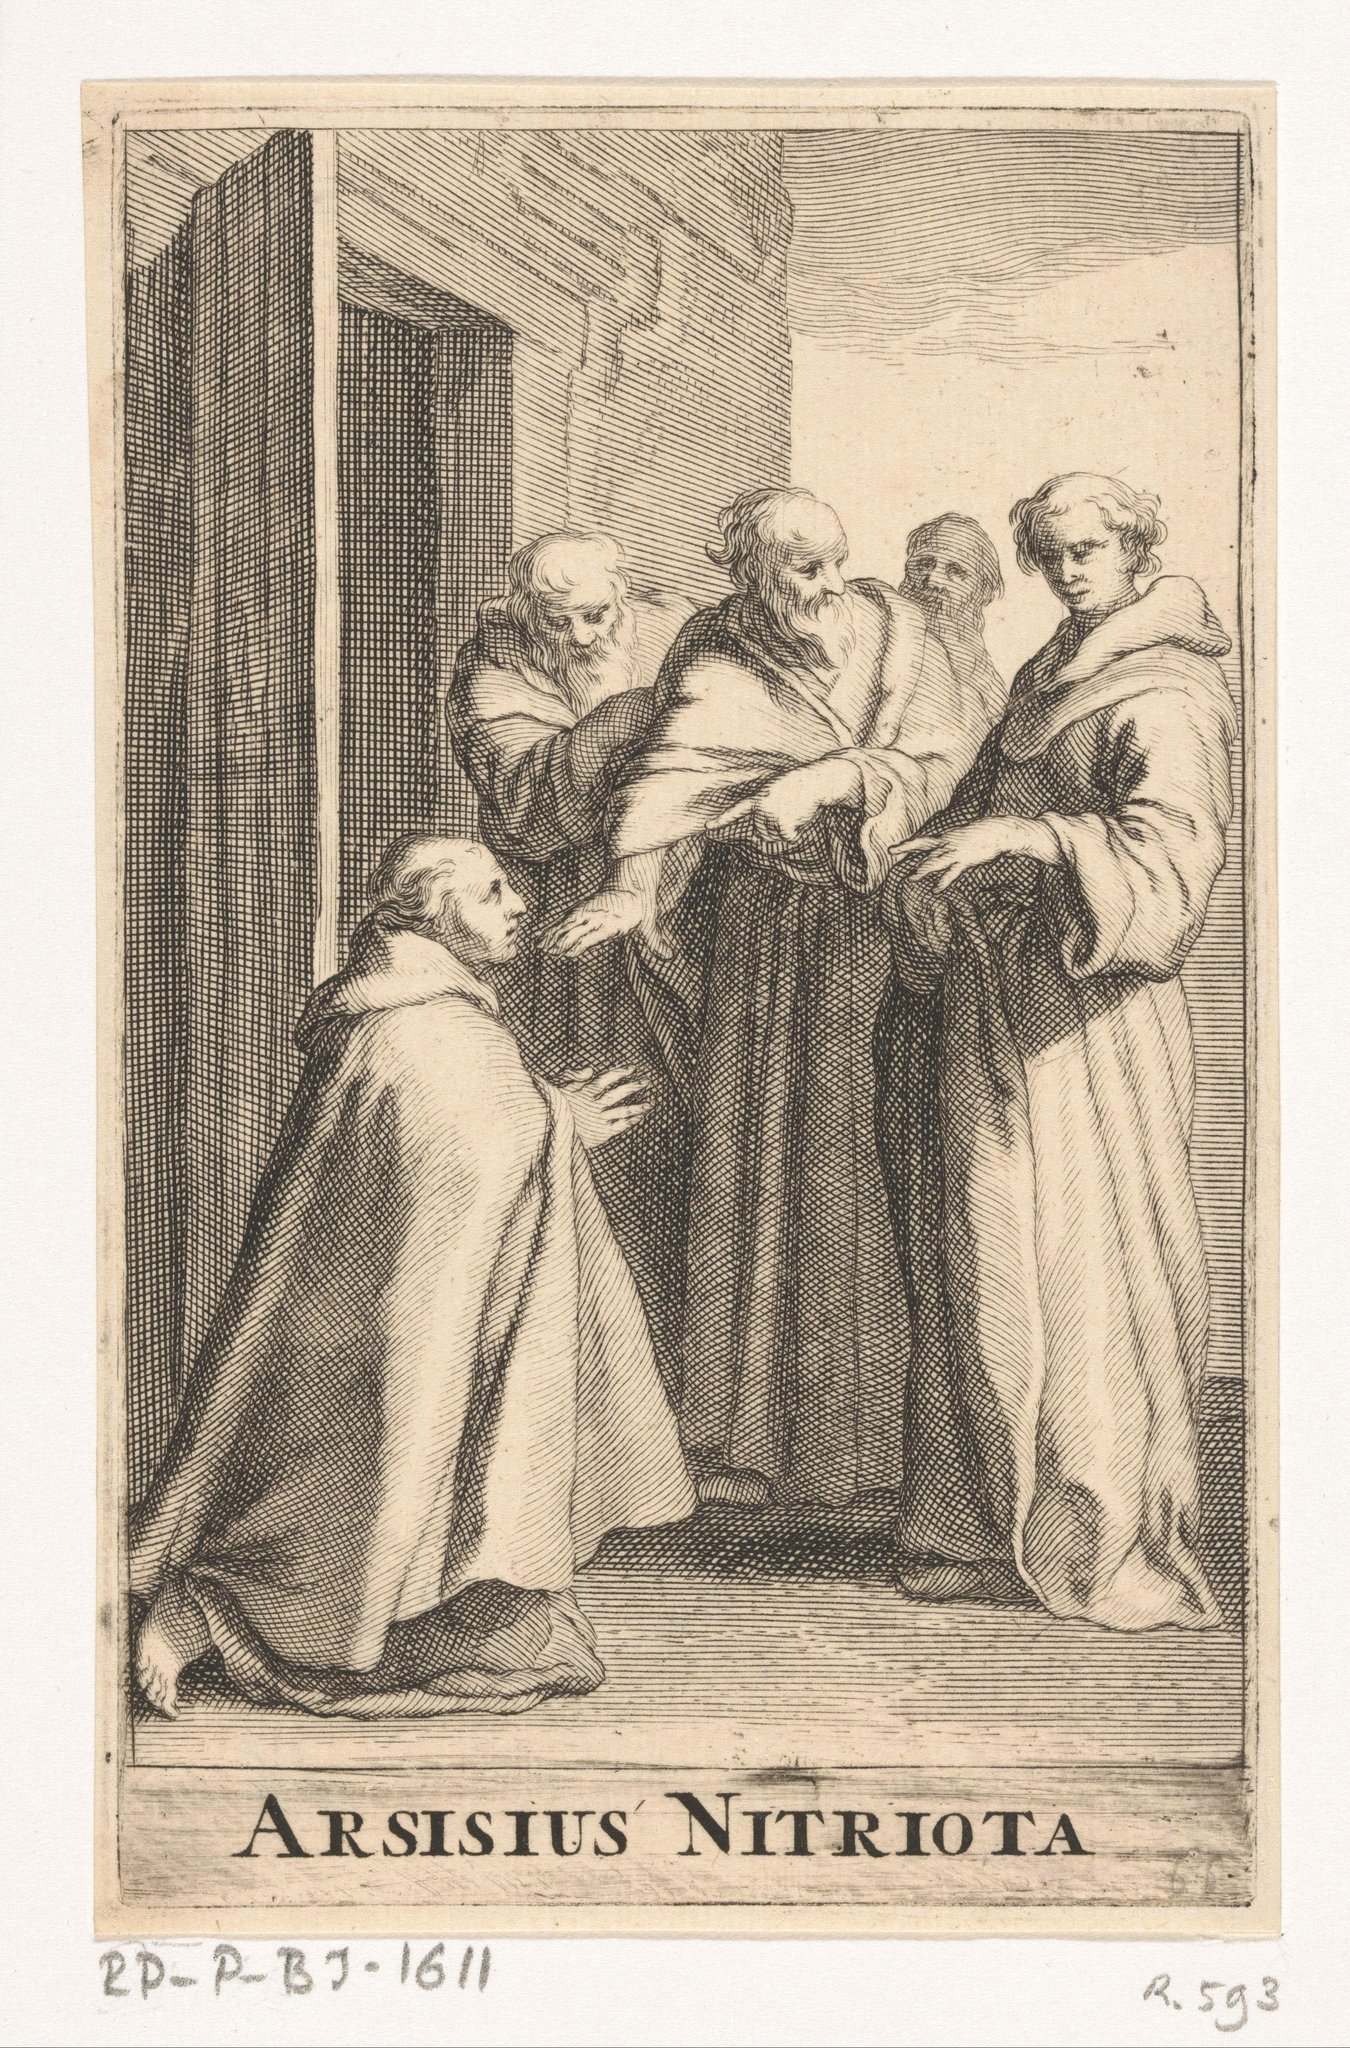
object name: print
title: Kluizenaars: Thebaanse heiligen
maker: frederick bloemaert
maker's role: print maker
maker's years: 1614-1669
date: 1636-1670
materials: paper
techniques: engraving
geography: utrecht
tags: male saints (arsisius)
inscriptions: collector's mark: Lugt 240, number: ‘66’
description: De heilige Arsisius in gezelschap van andere kluizenaars. Een van hen knielt neer. Prent uit een serie van 80 prenten en een titelprent met kluizenaars uit de 2e tot de 6e eeuw.